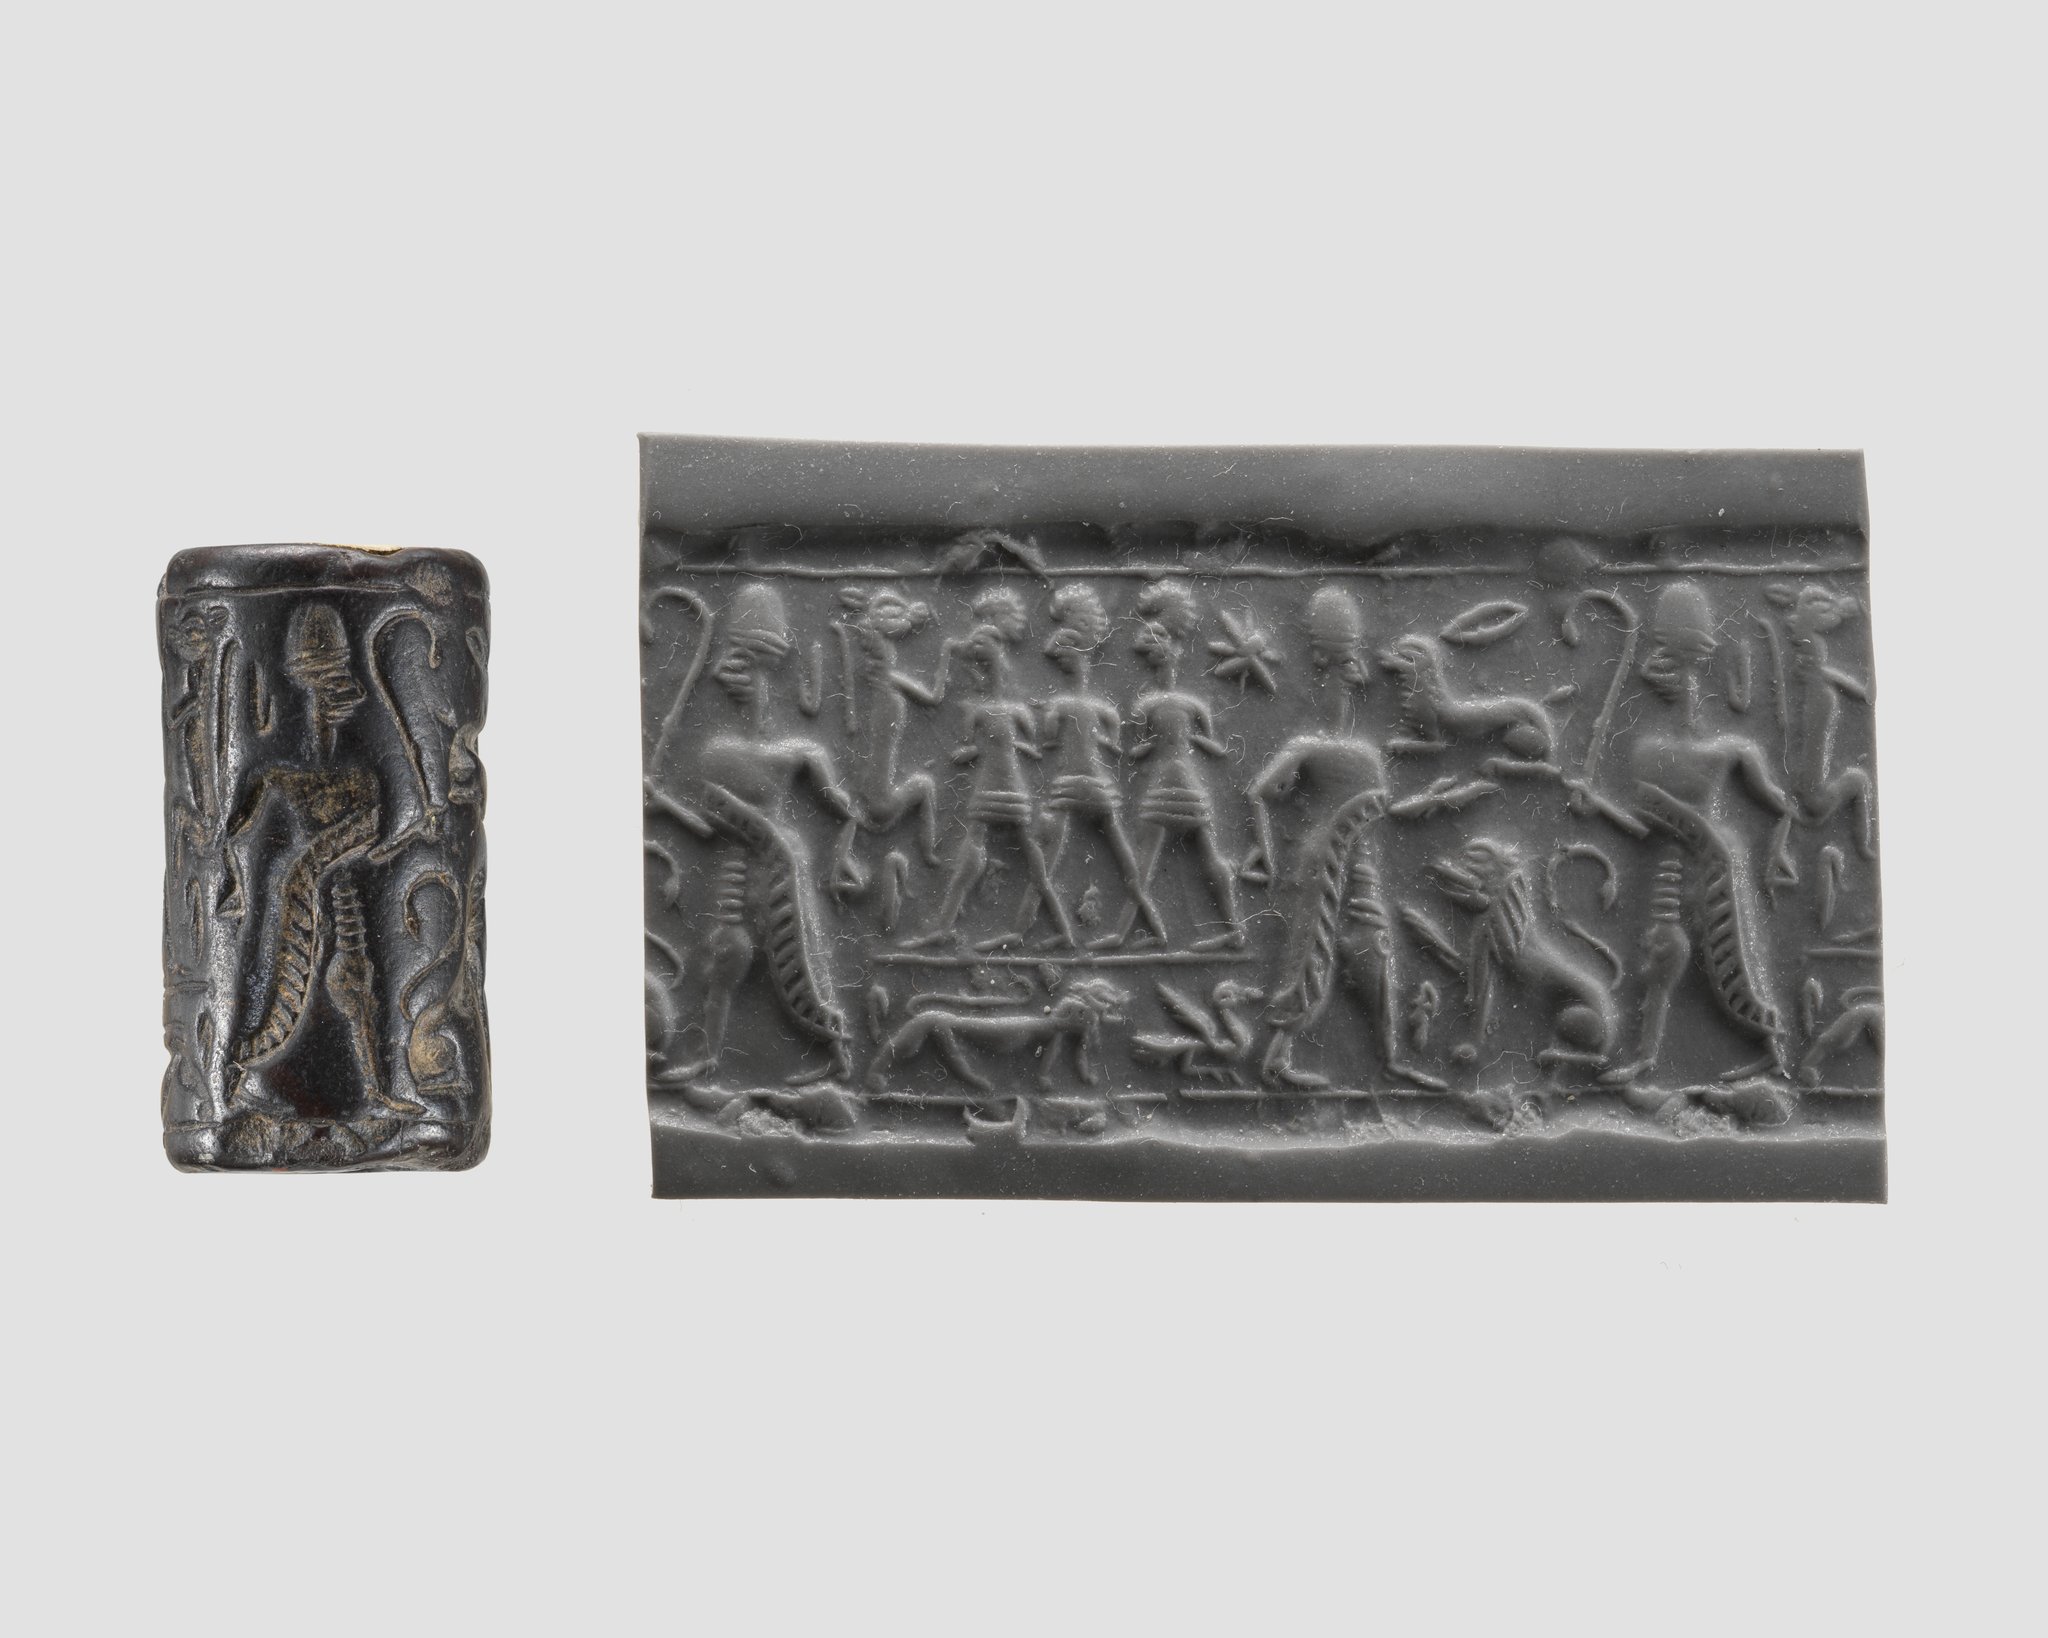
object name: cylinder seal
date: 1820-1730 BCE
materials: mineral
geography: syria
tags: animals